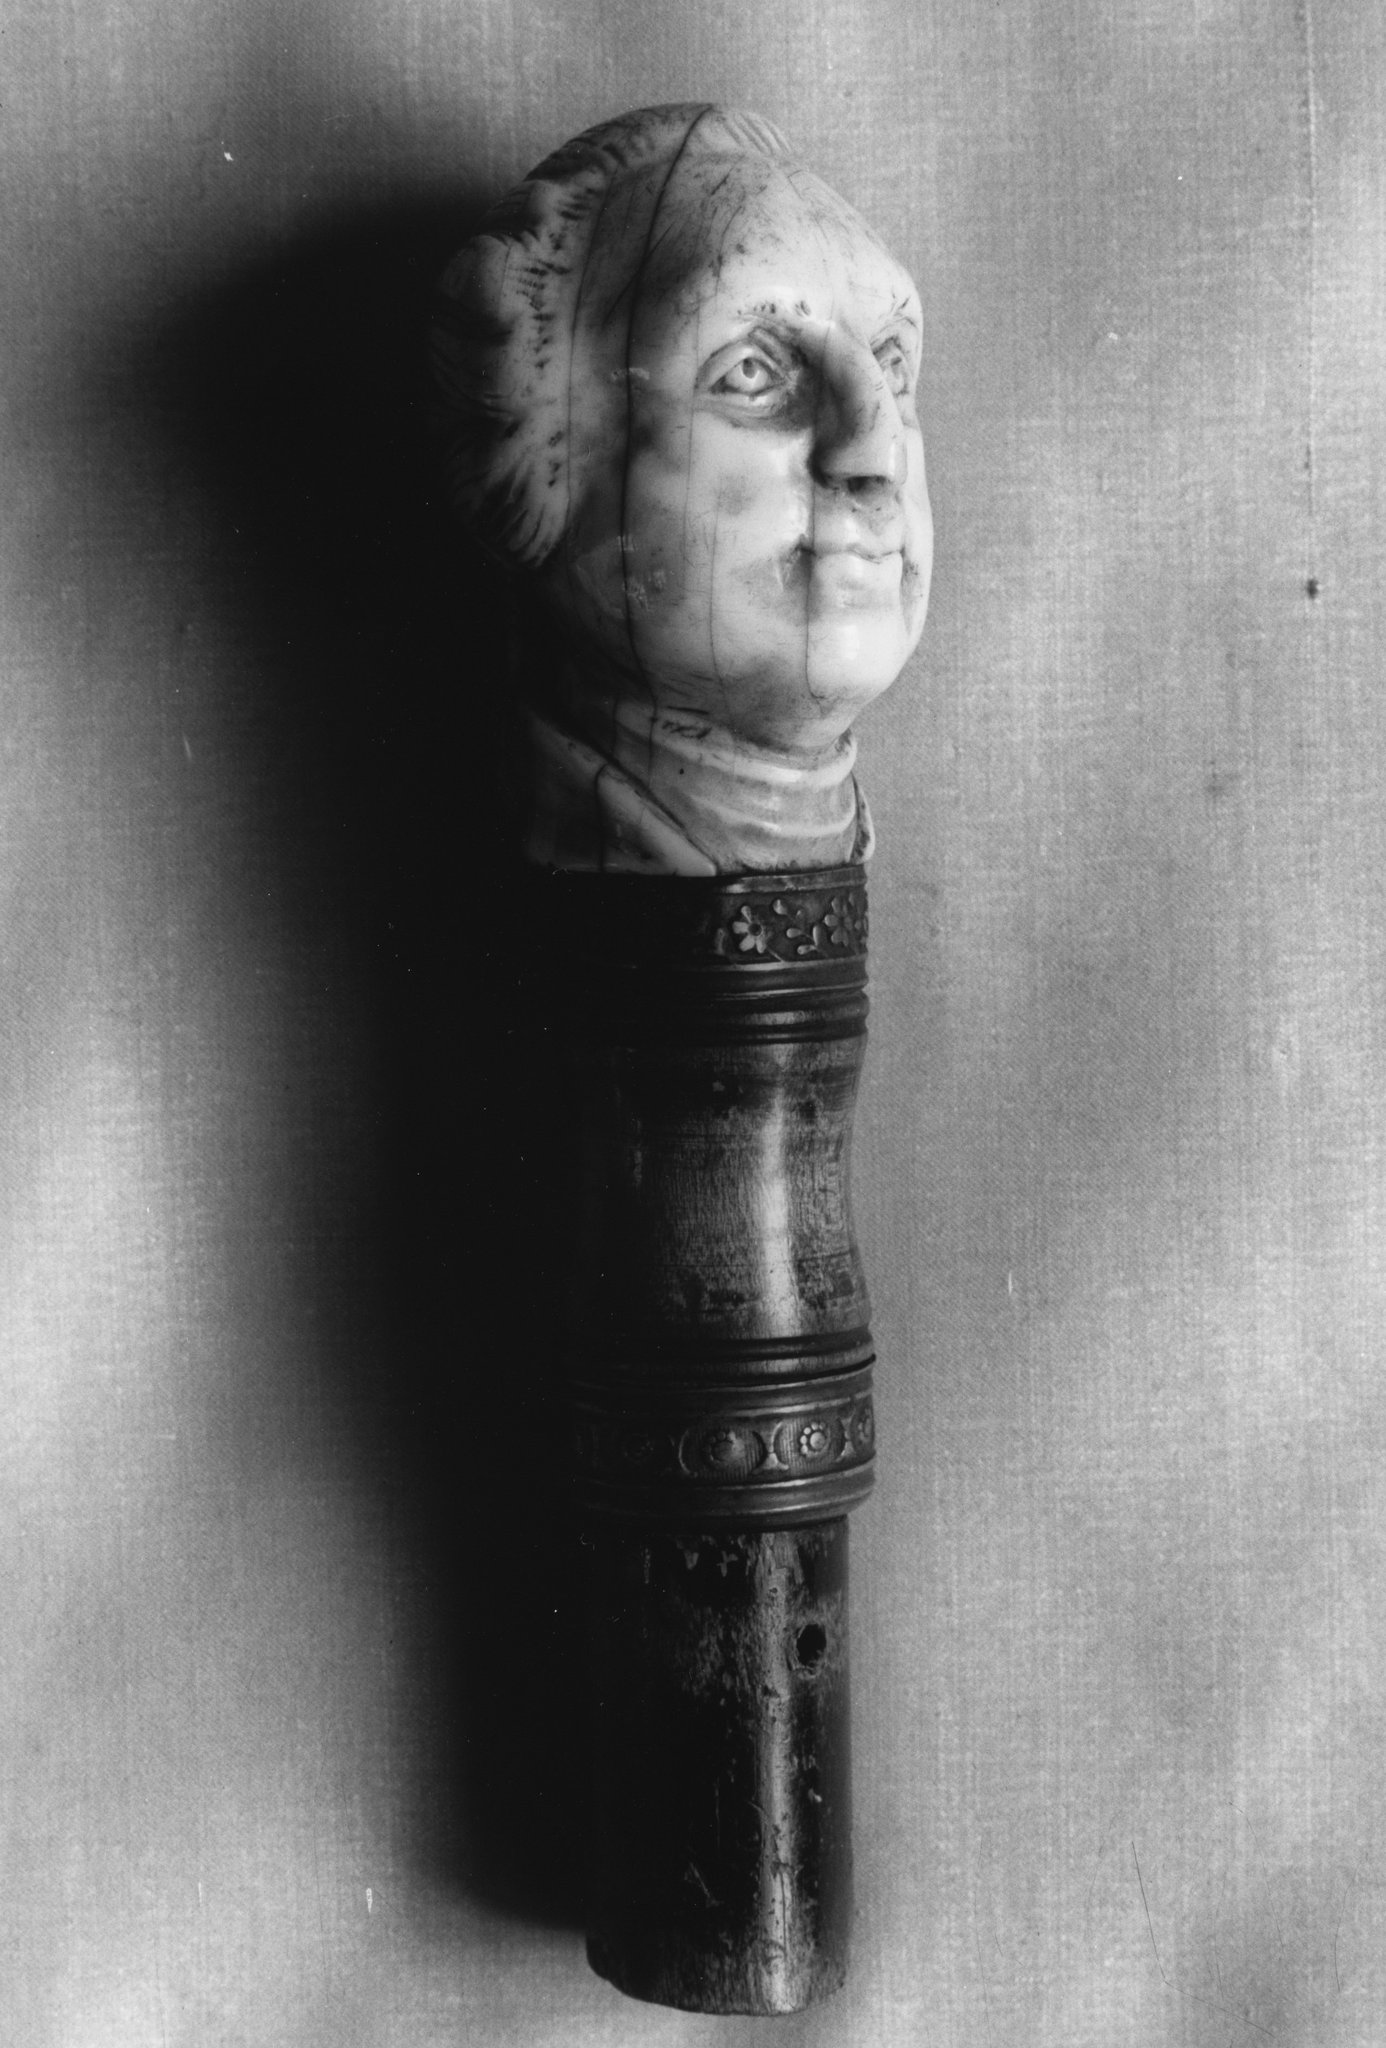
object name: cane handle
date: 1770-1800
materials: brass, ivory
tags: faces,men